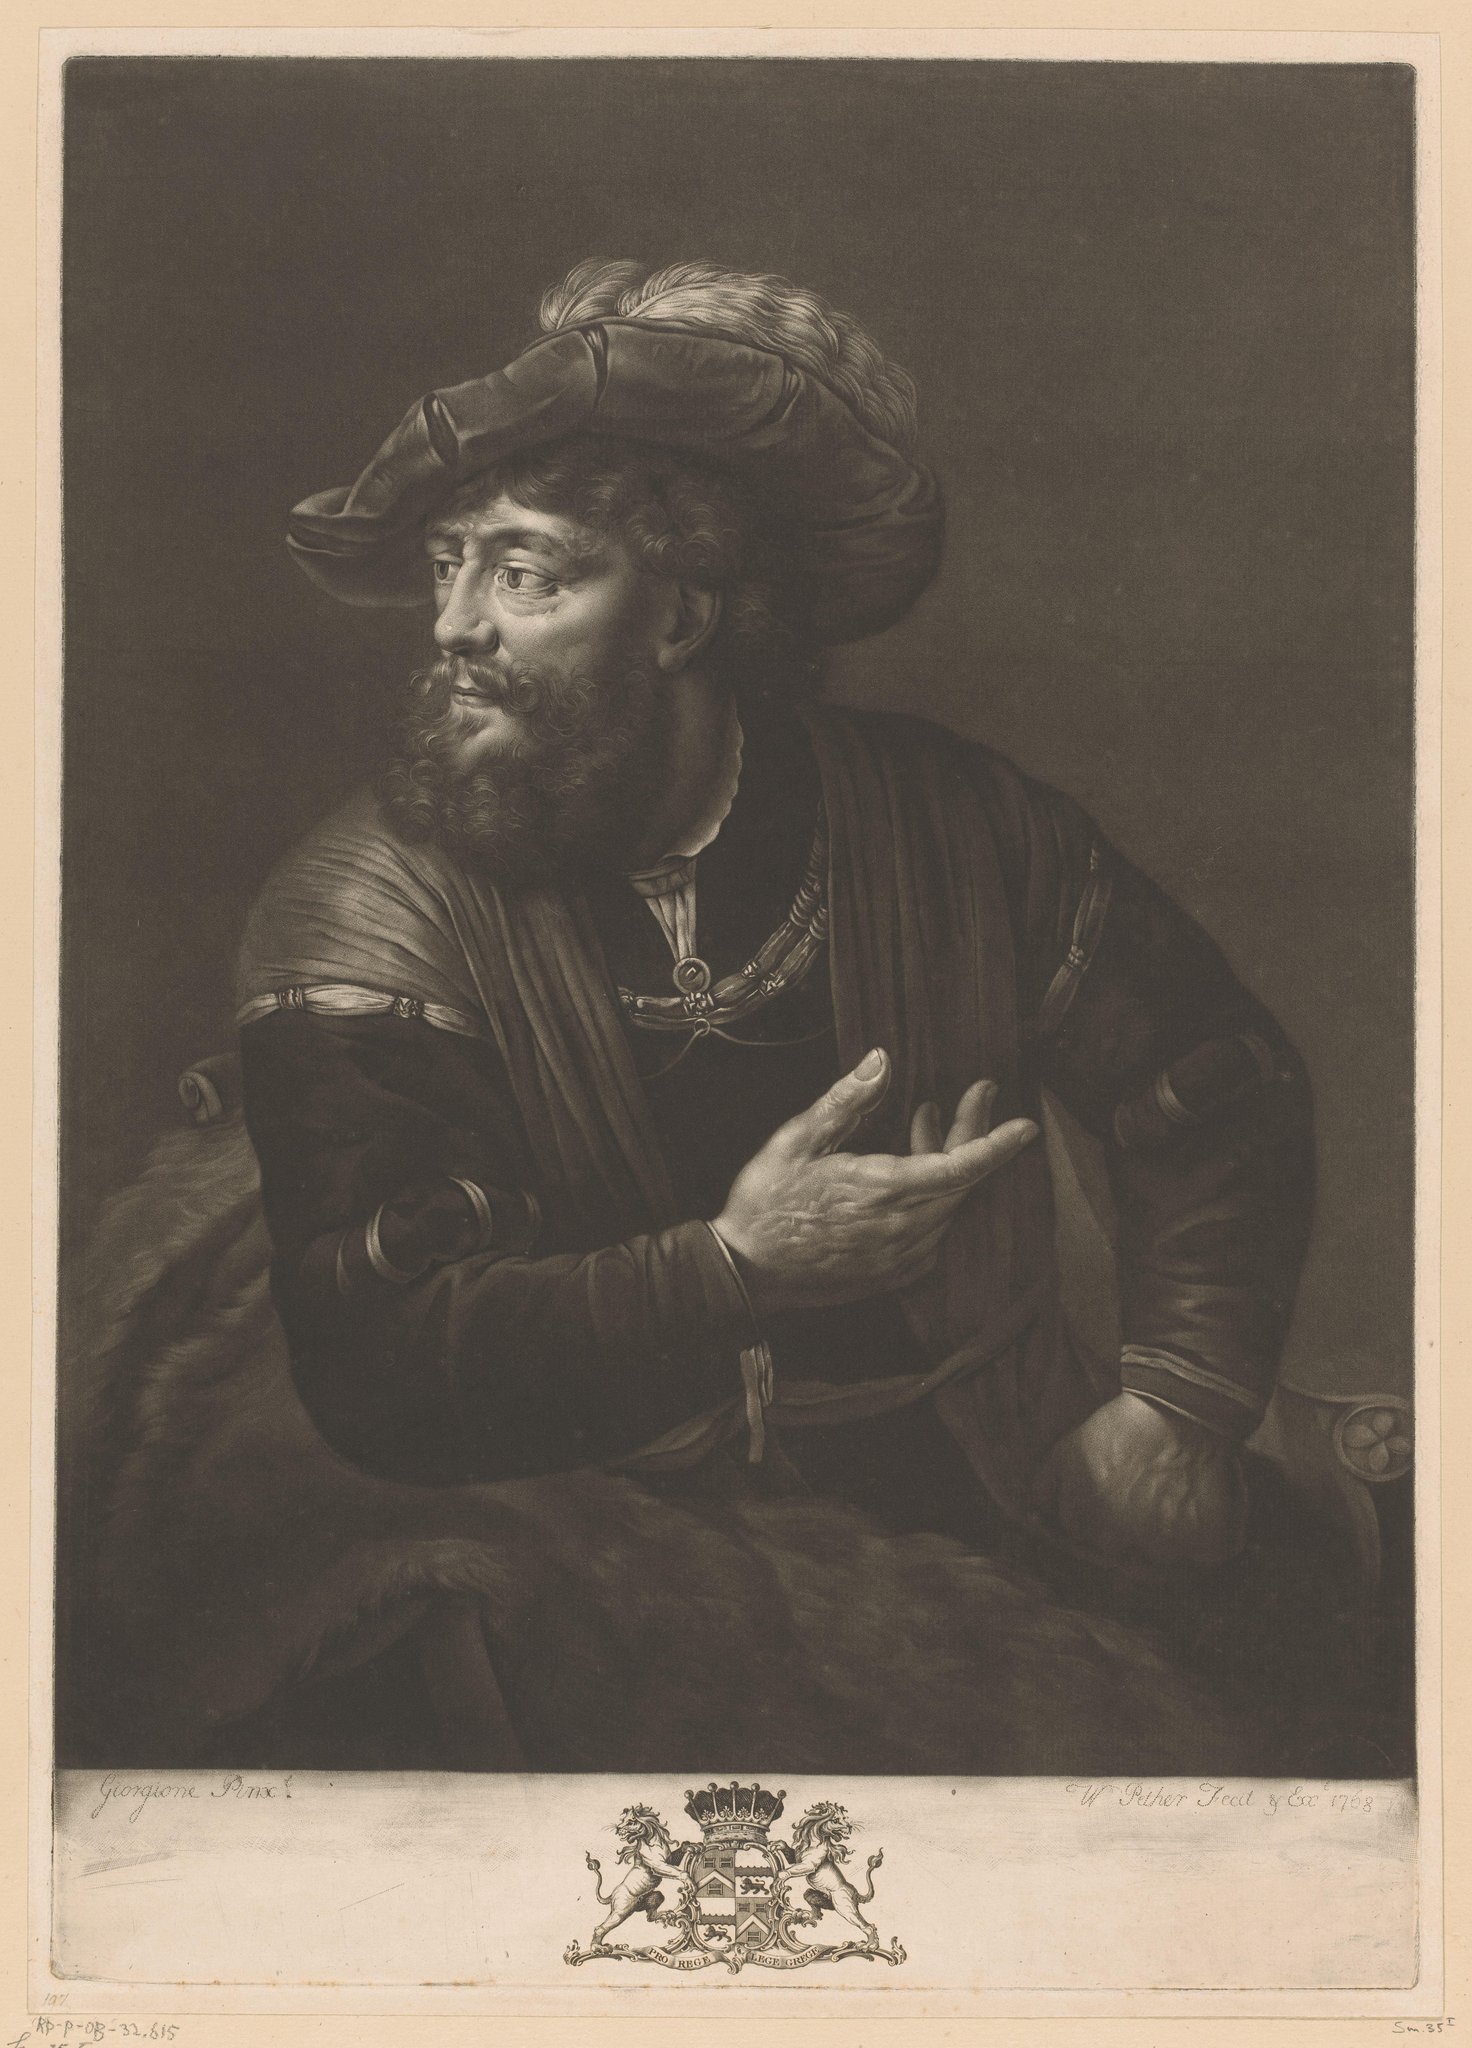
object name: print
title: Portret van een onbekende man uit Venetië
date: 1768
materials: paper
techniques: etching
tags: historical persons, merchant, salesman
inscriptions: collector's mark: Lugt 240